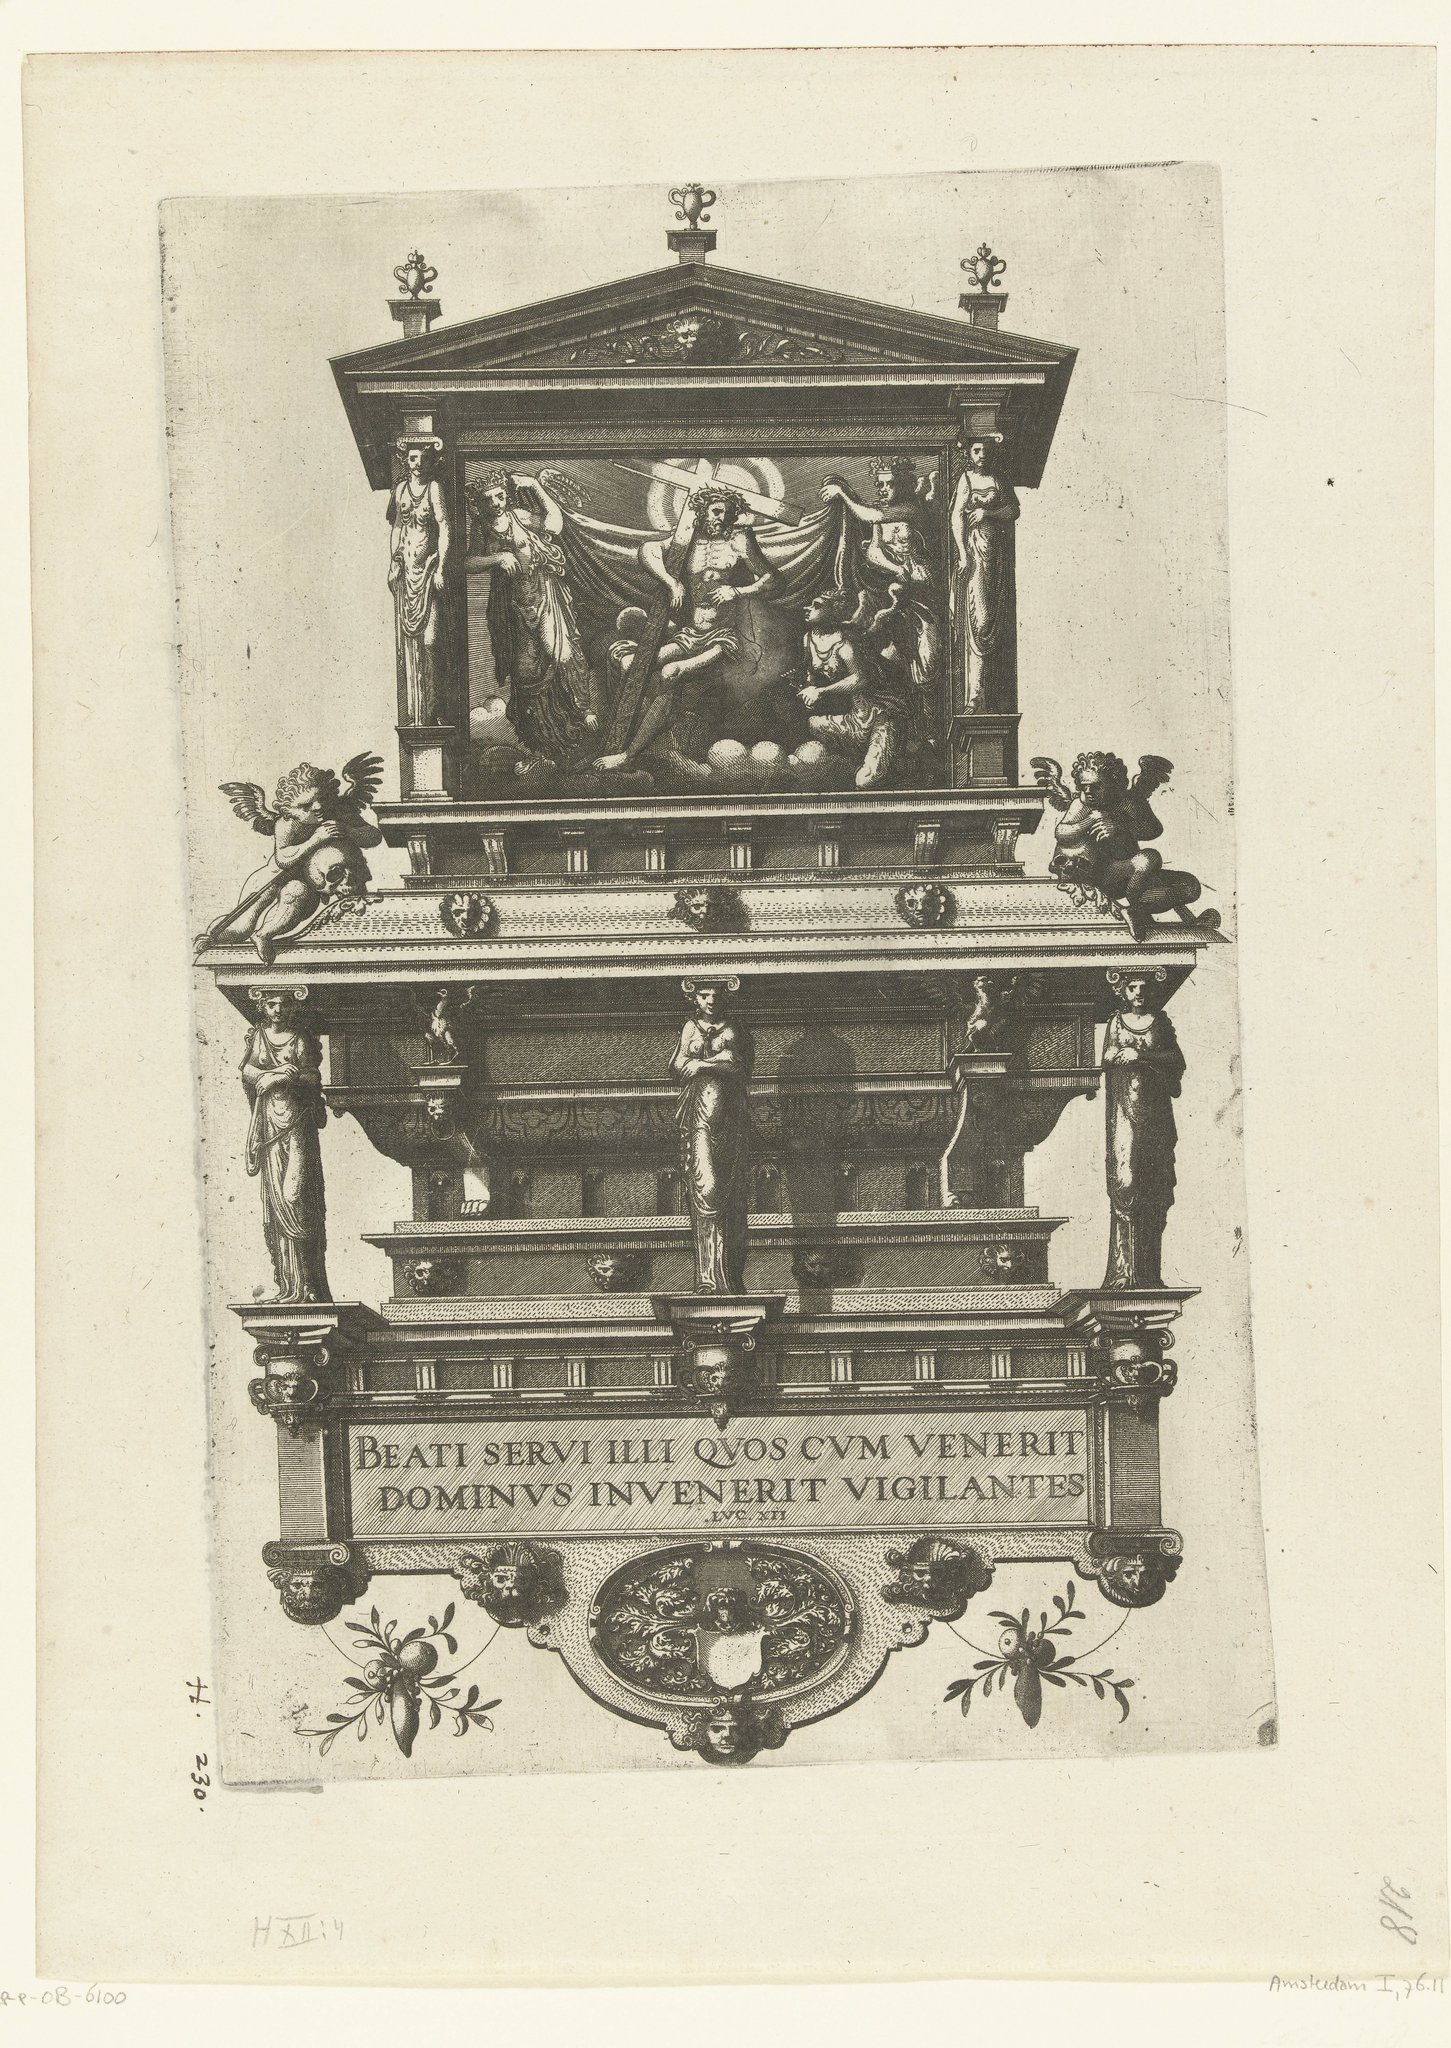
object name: ornament print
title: Epitaaf met Christus tussen engelen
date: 1557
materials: paper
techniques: etching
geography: netherlands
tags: ornaments ~ art, adult christ together with angels, gravestone, tombstone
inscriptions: : ‘BEATI SERVI ILLI QUOS CUM VENERIT / DOMINUS INVENERIT VIGGILANTES (Luc. xii)’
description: Tegen een wand hangt een sarcofaag waarvan het deksel door drie kariatiden wordt ondersteund. Bovenaan bekroont een driehoekig fronton een voorstelling van Christus met kruis tussen drie engelen. Hoort bij serie bestaande uit een titelblad, een tekstblad en 14 bladen met grotesken met rolwerk, saters, guirlandes, trofeeën, dieren en fantasiewezens.